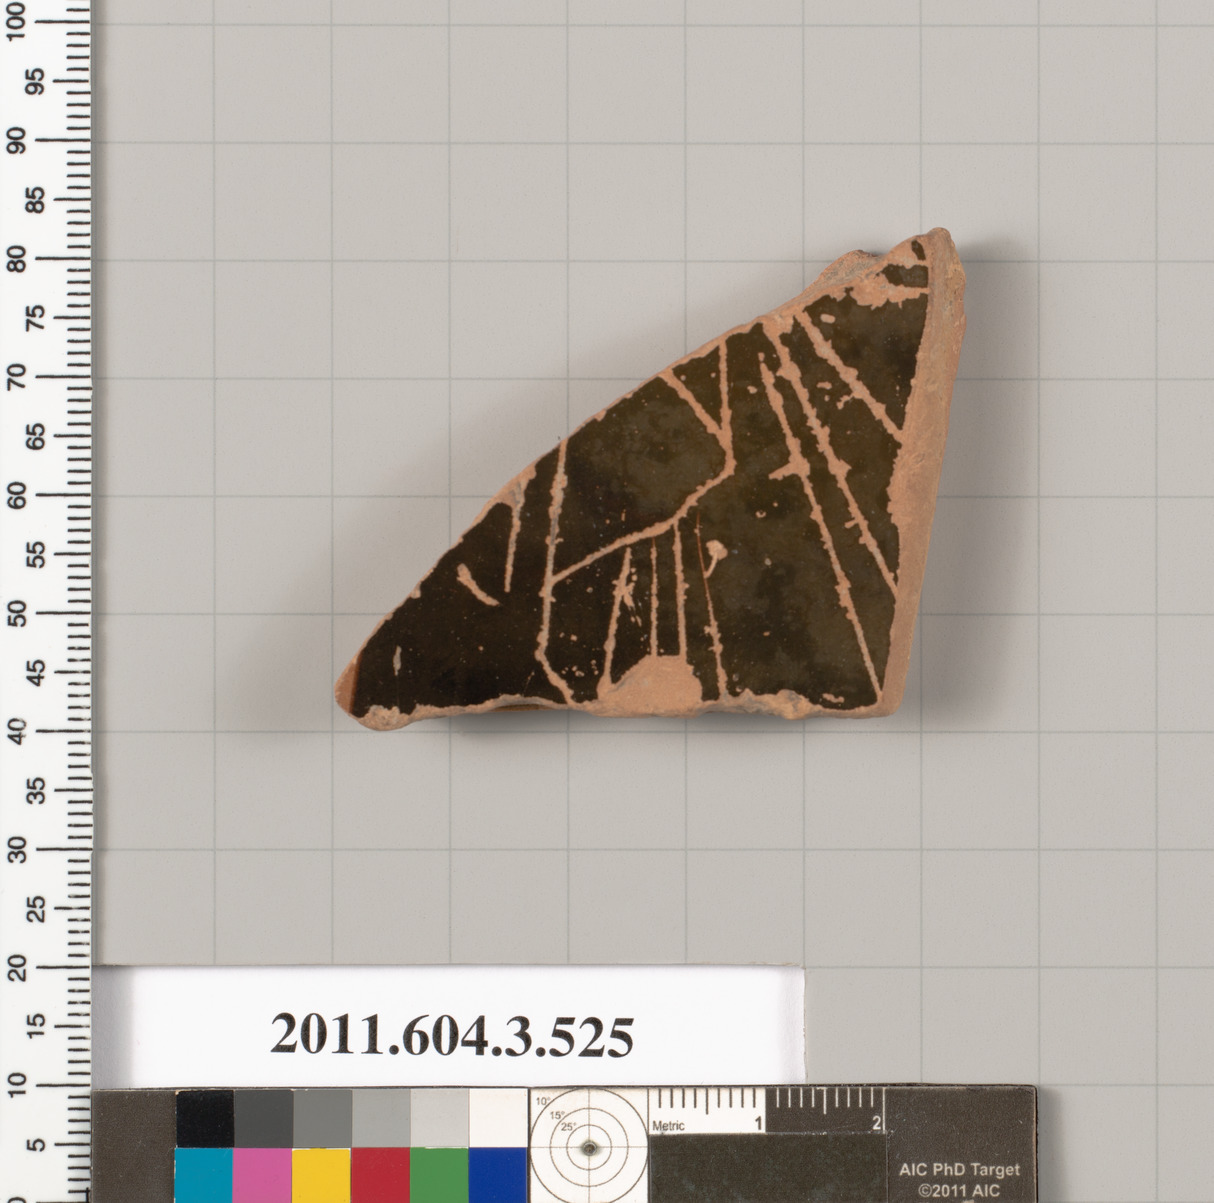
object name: calyx krater or column krater fragment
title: Terracotta fragment of a column-krater (bowl for mixing wine and water) or a calyx-krater (bowl for mixing wine and water)?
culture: greek, attic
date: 510-500 BCE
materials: terracotta